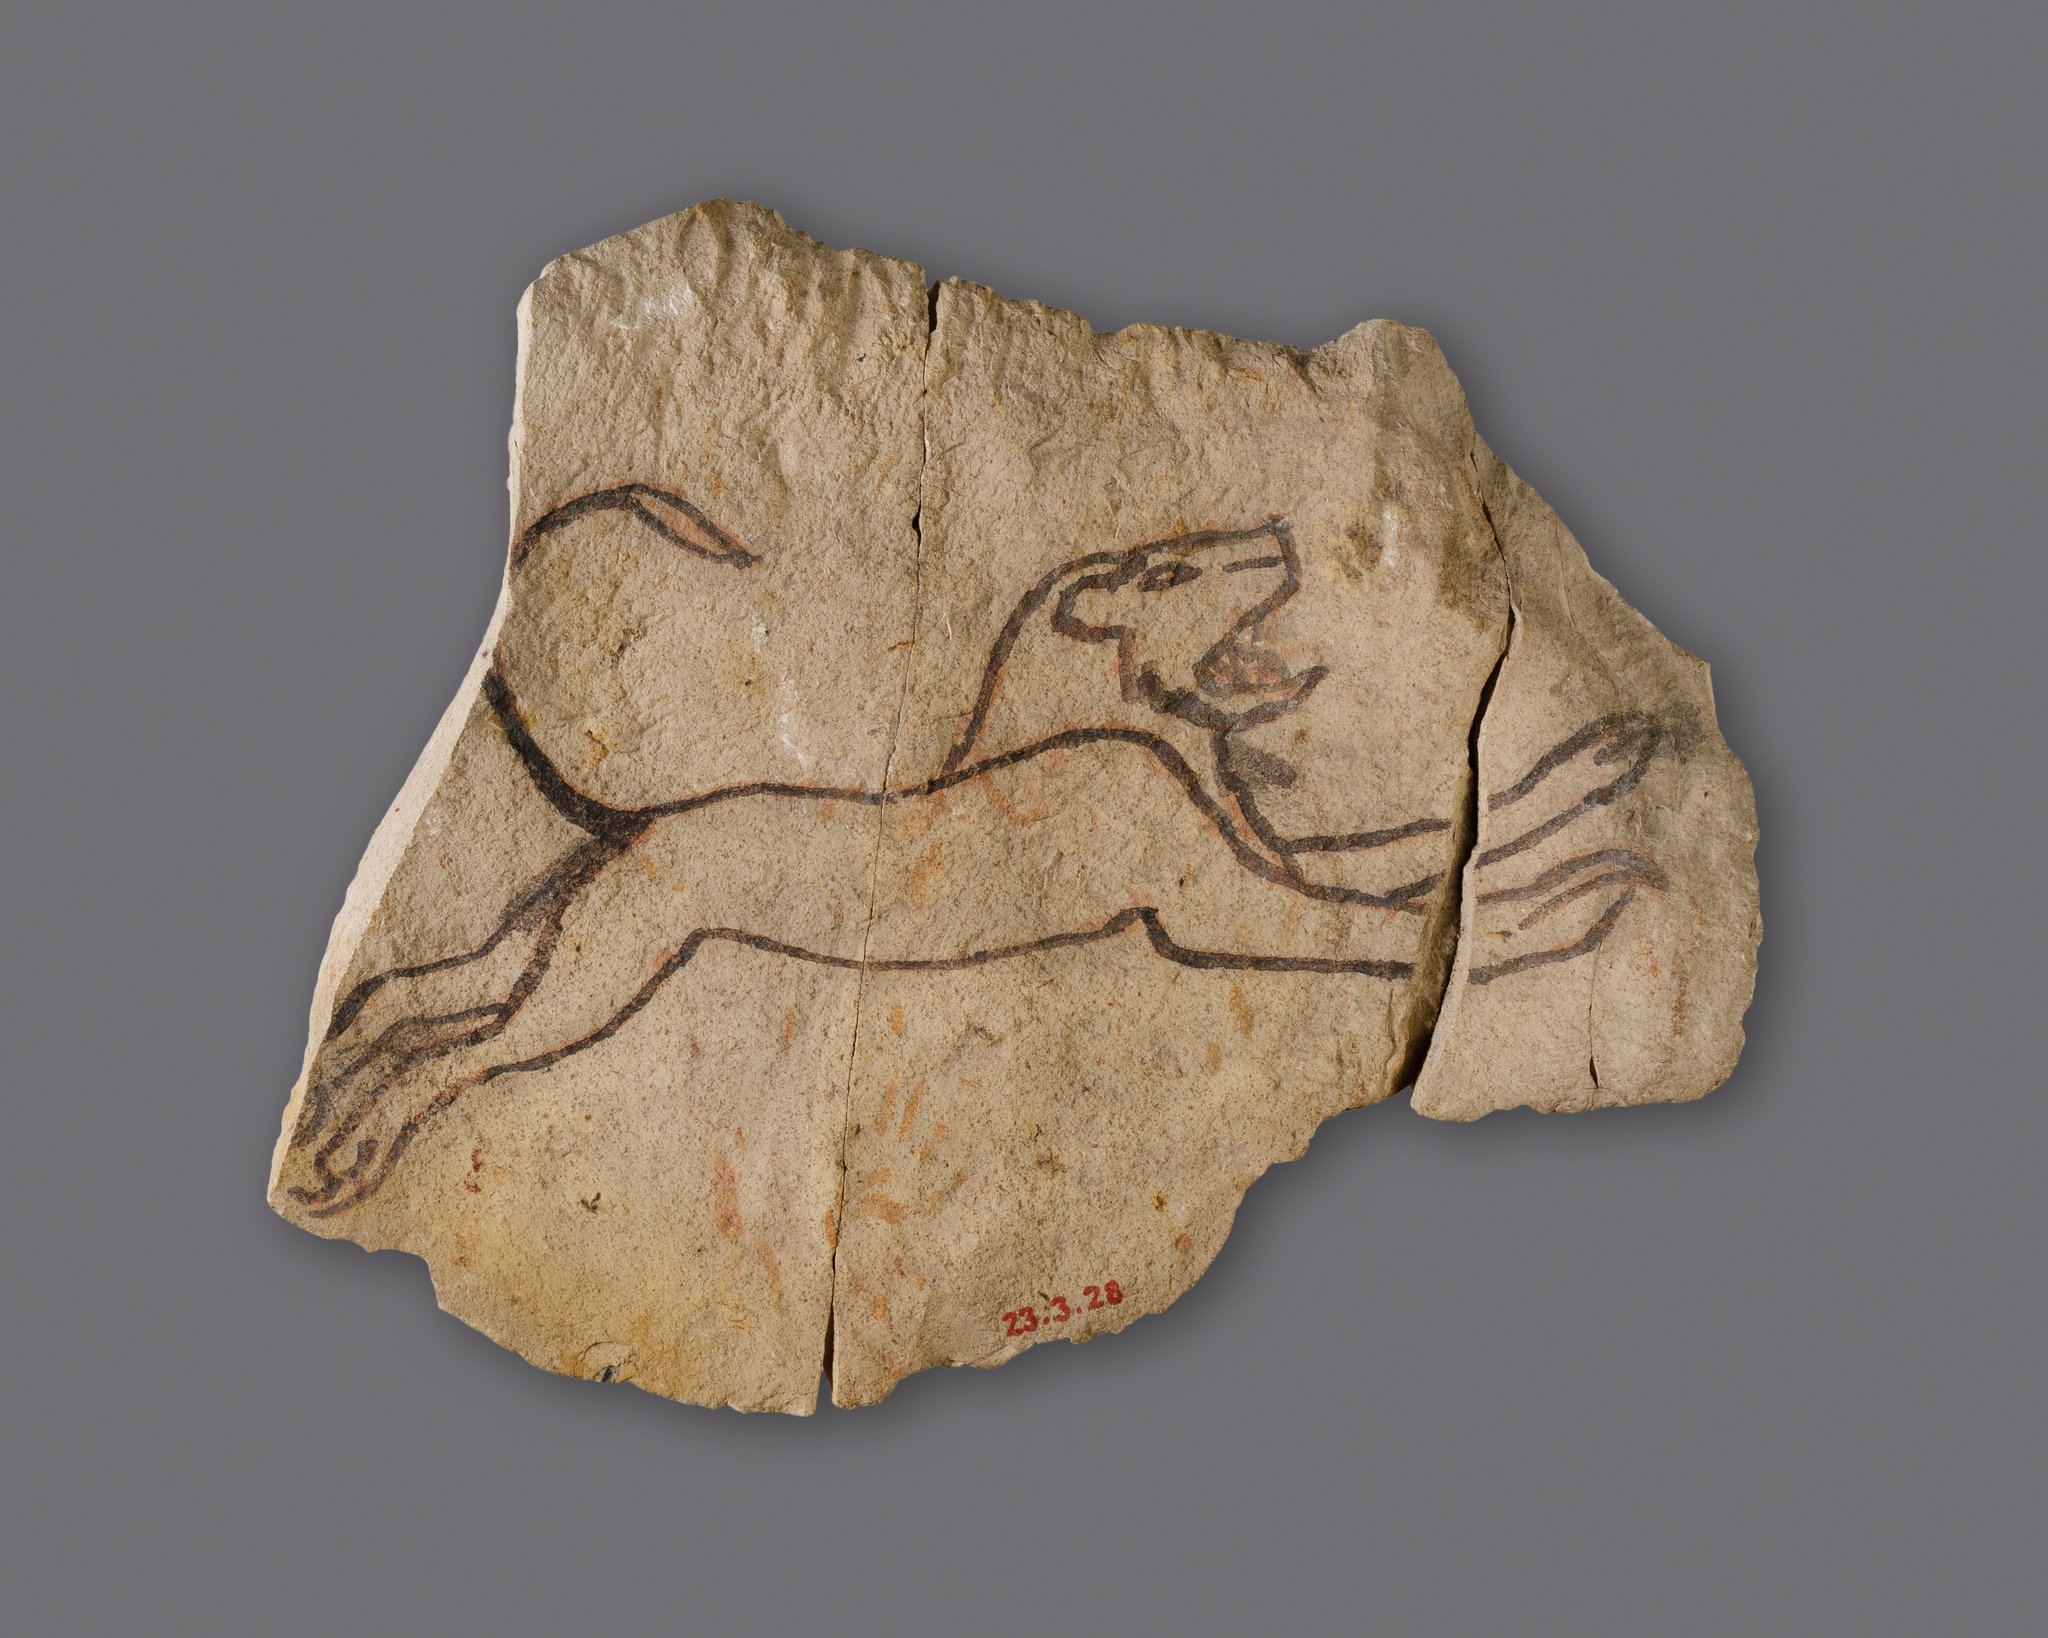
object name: ostracon, figured, lion running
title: Ostracon with sketch of a running lion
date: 1295-1070 BCE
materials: ink, limestone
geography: egypt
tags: lions